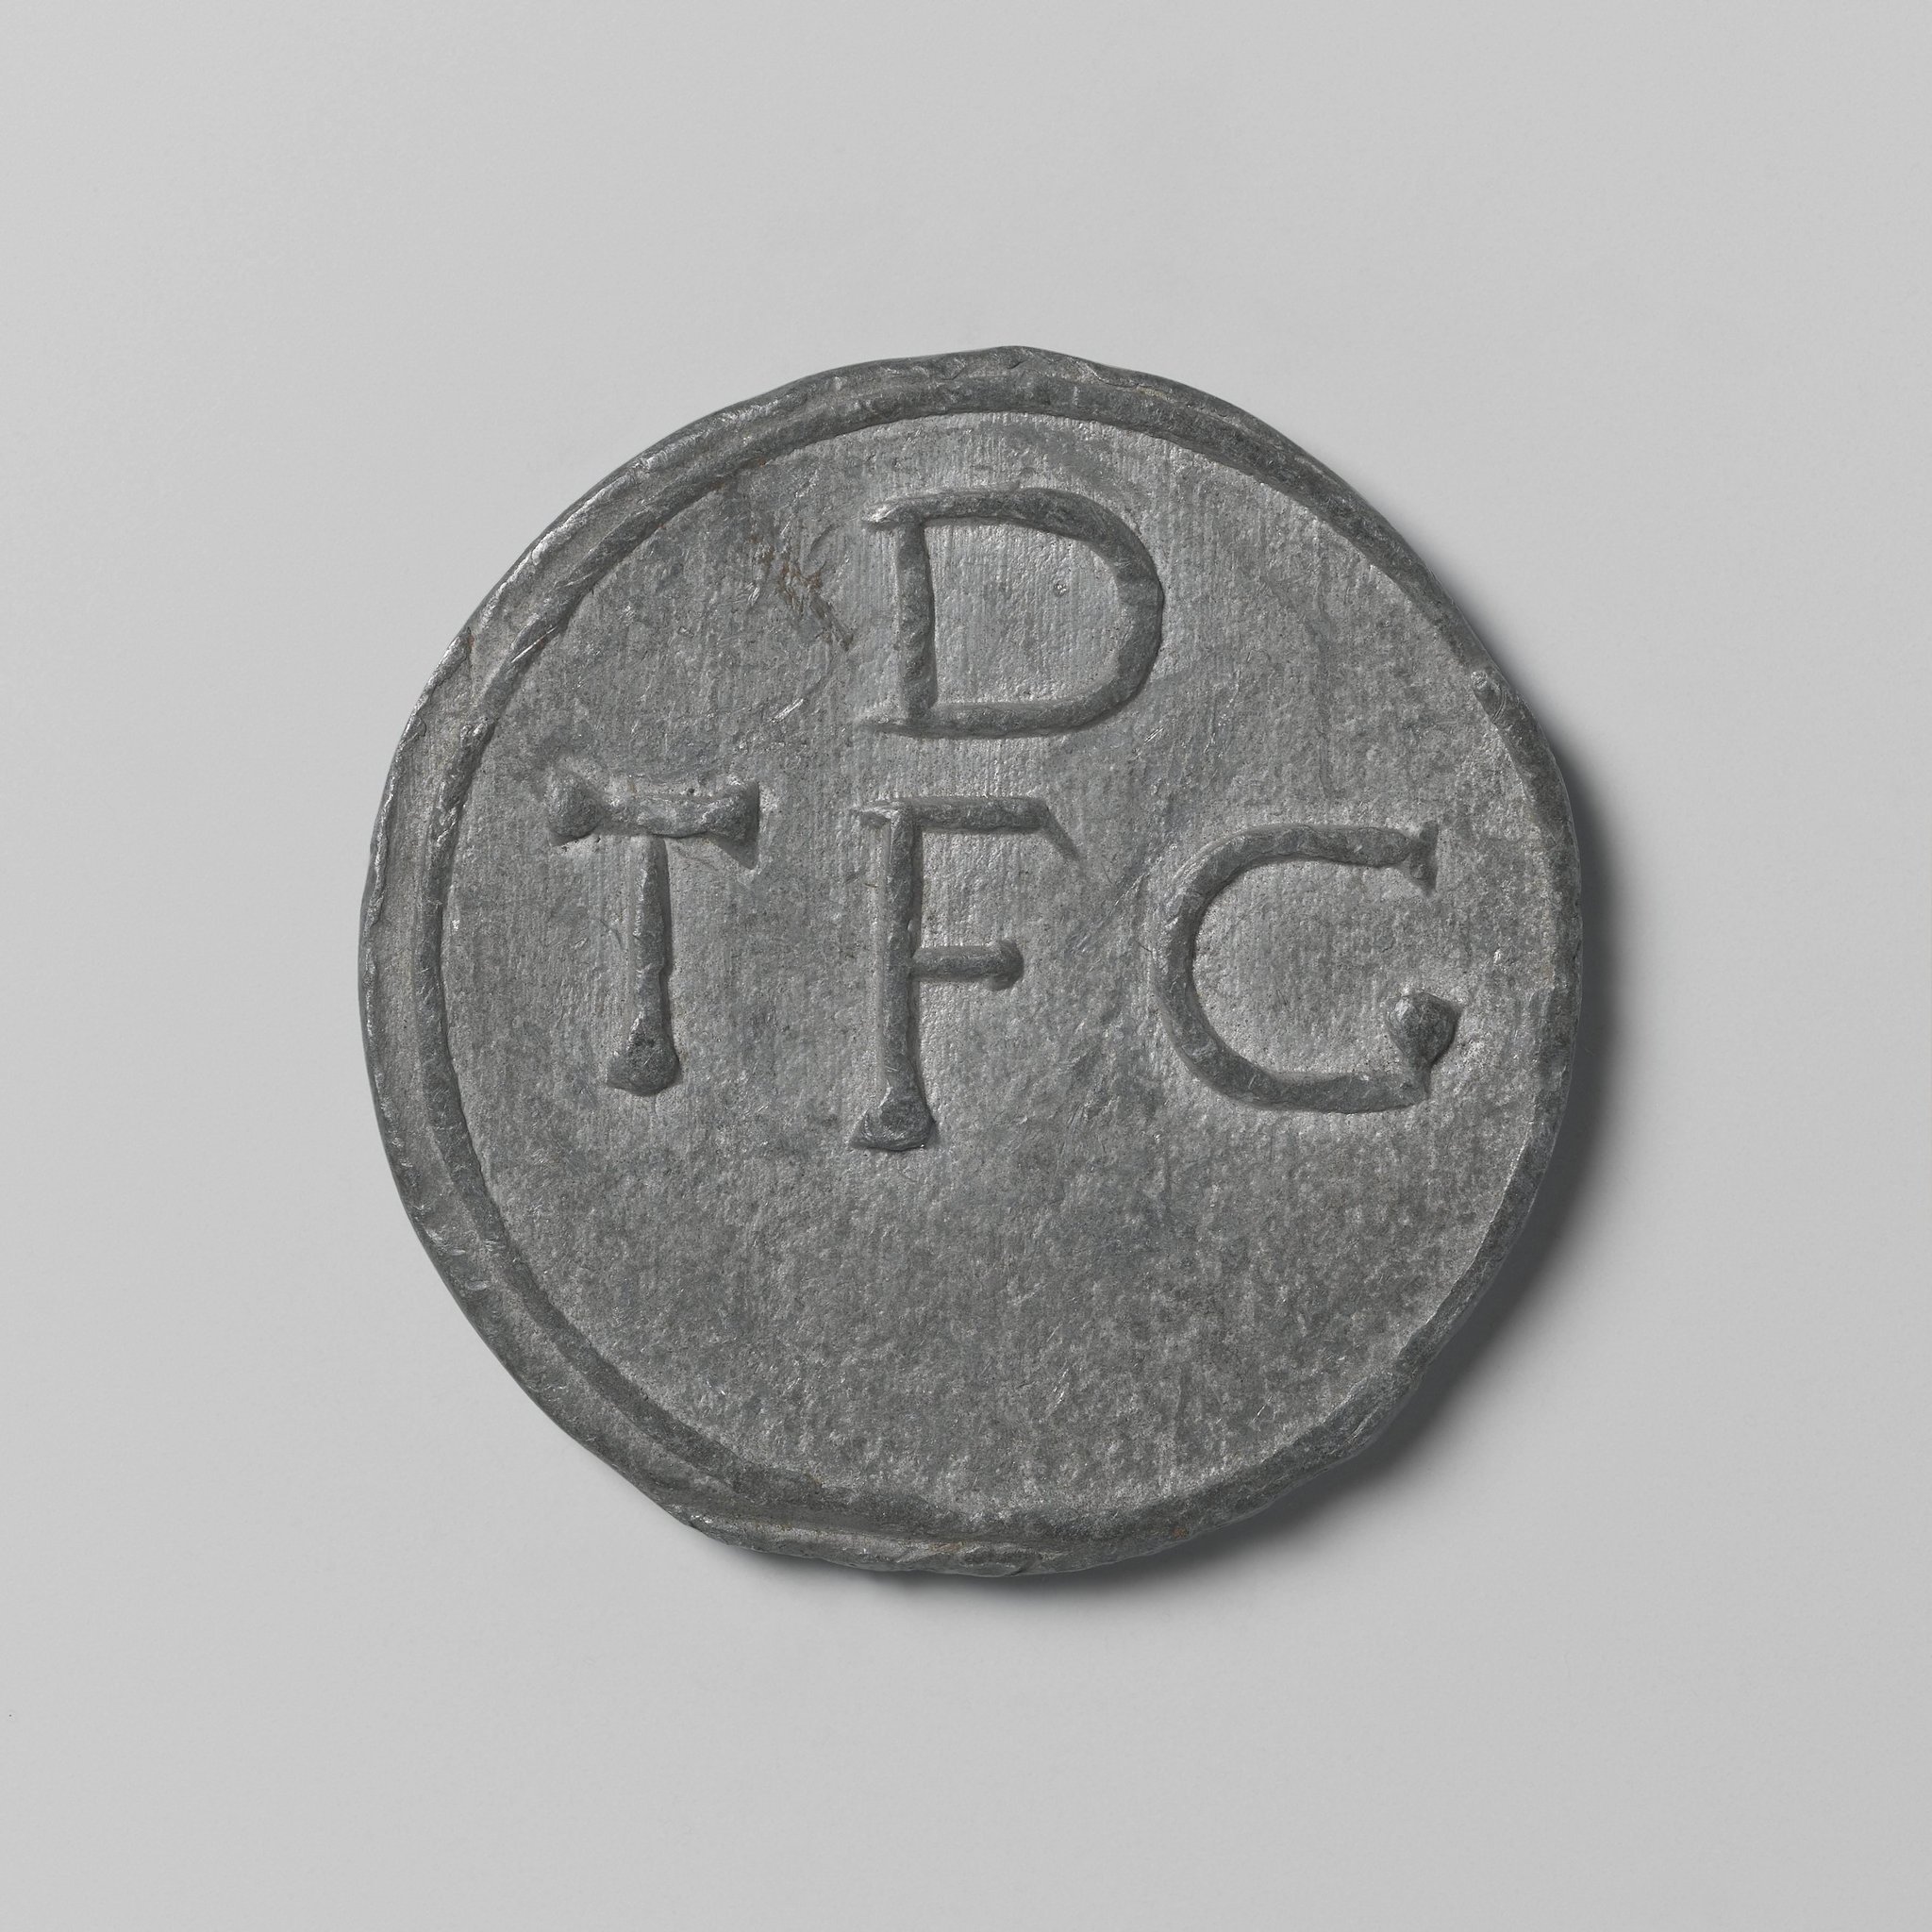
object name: presentiepenning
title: Turfdragersgilde van Amsterdam, presentiepenning met letter F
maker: Anonymous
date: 1600-1800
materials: lead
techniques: casting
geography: amsterdam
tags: amsterdam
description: Loden penning. Voorzijde: brandemmer. Keerzijde: letters T, D en G; onder D: letter F